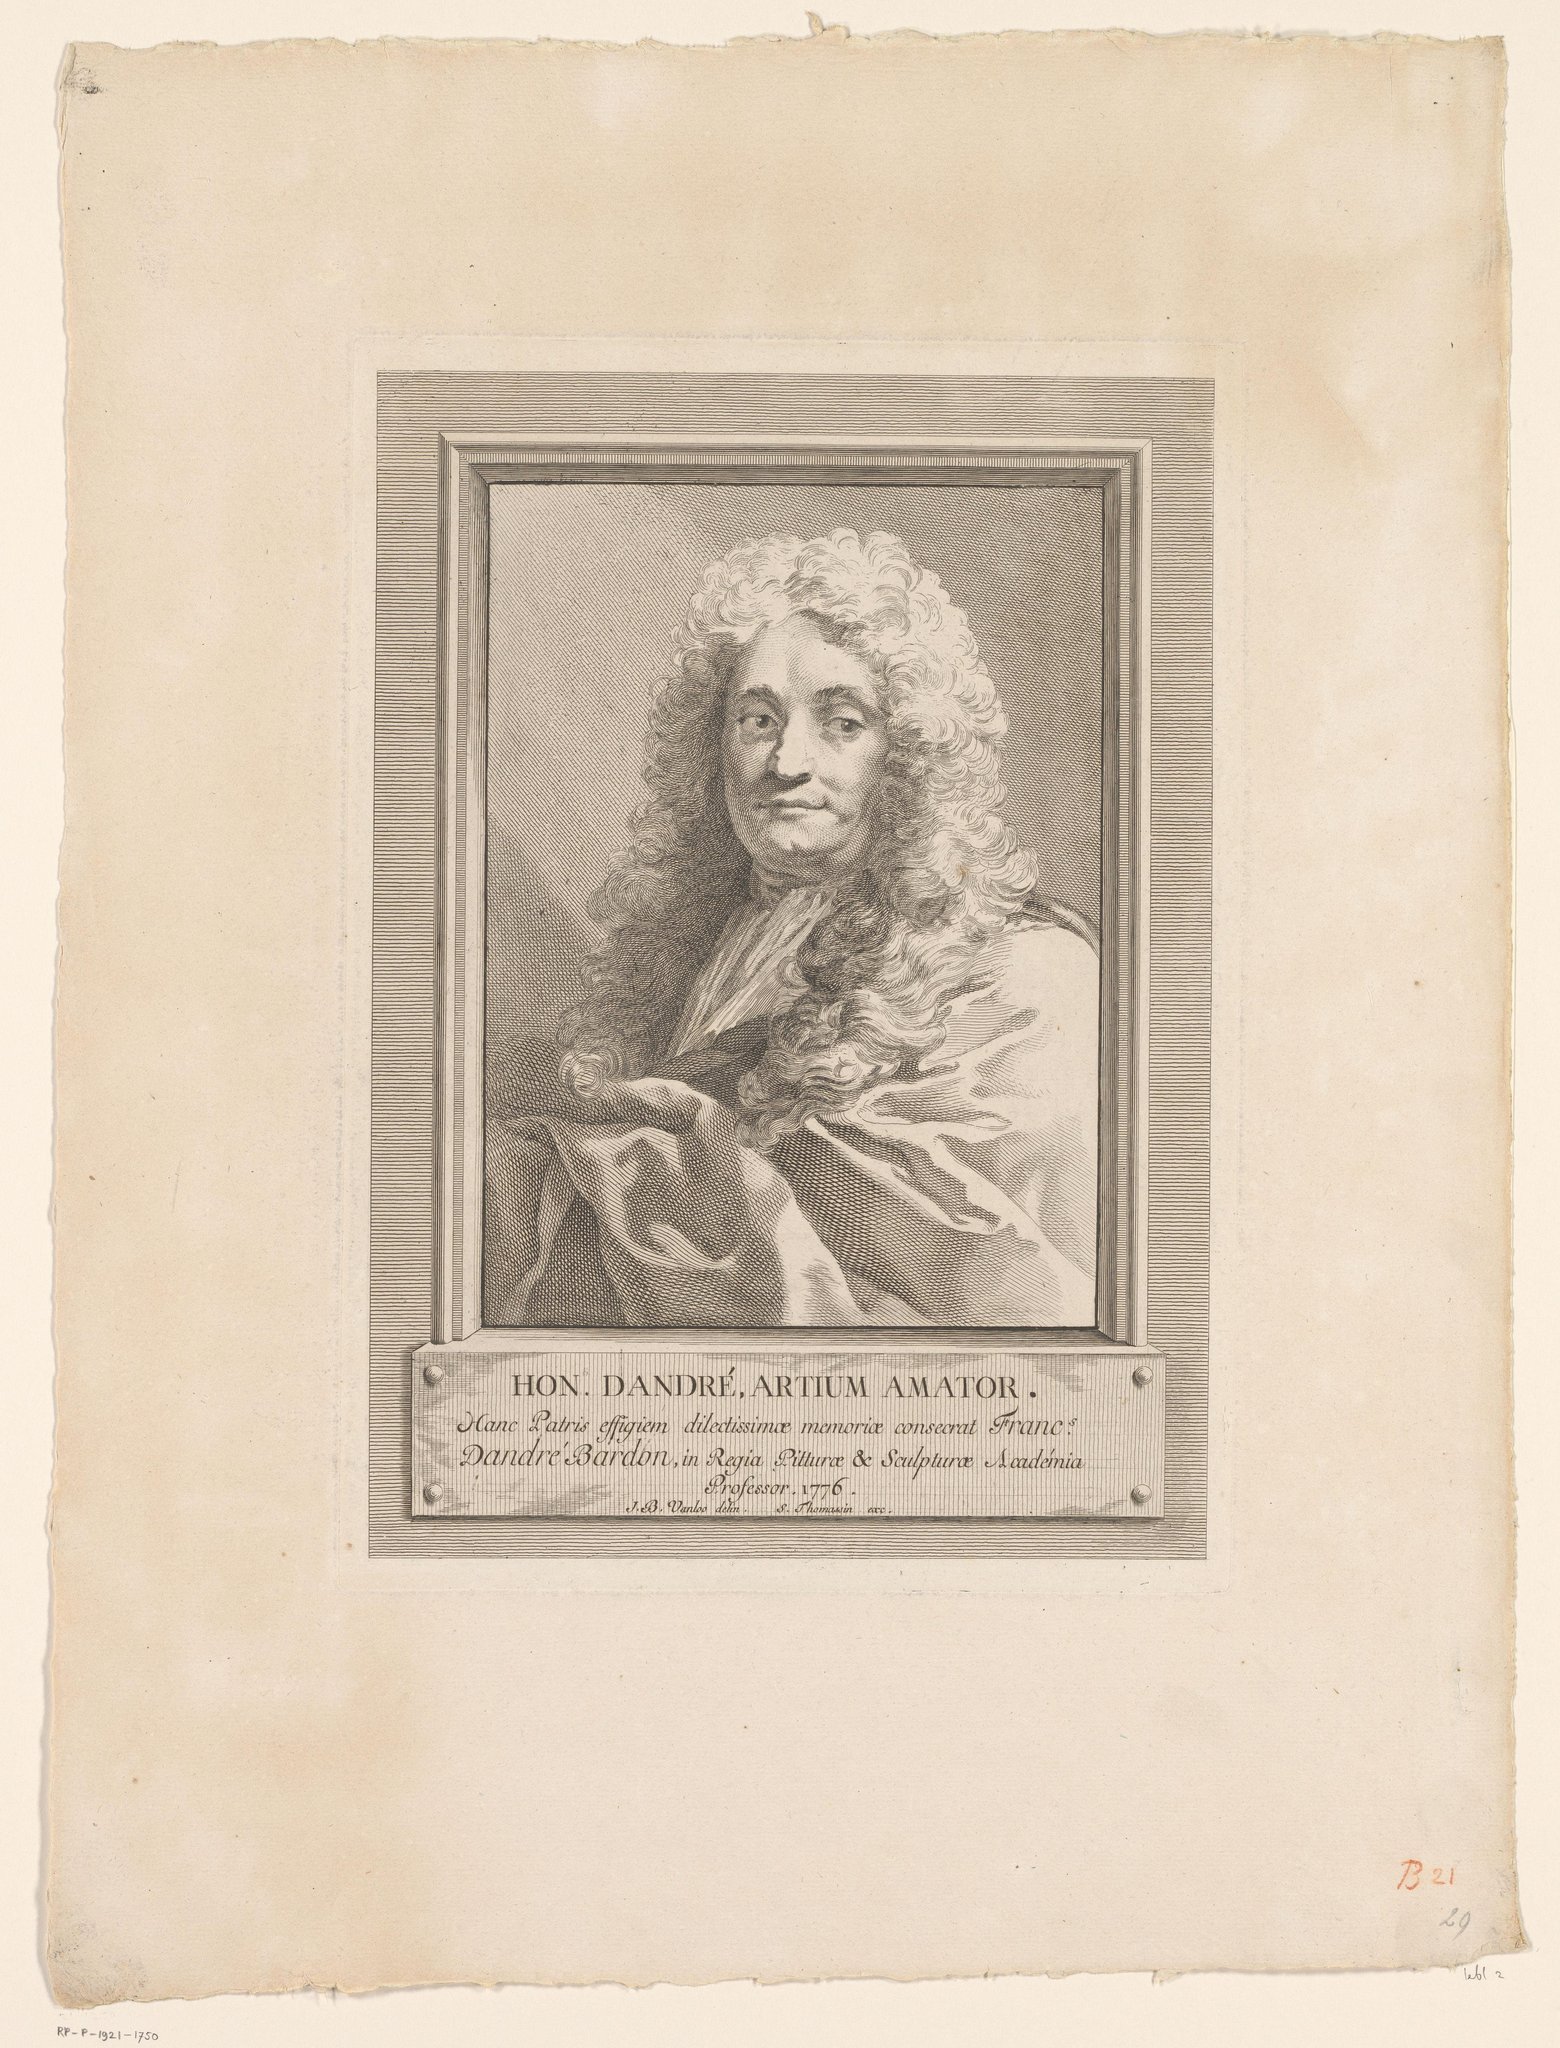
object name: print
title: Hon. dandré, Artium Amator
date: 1665-1733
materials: paper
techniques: engraving, etching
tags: paris, print maker, michel françois dandré-bardon, historical persons, portrait, self-portrait of painter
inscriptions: collector's mark: Lugt 2233